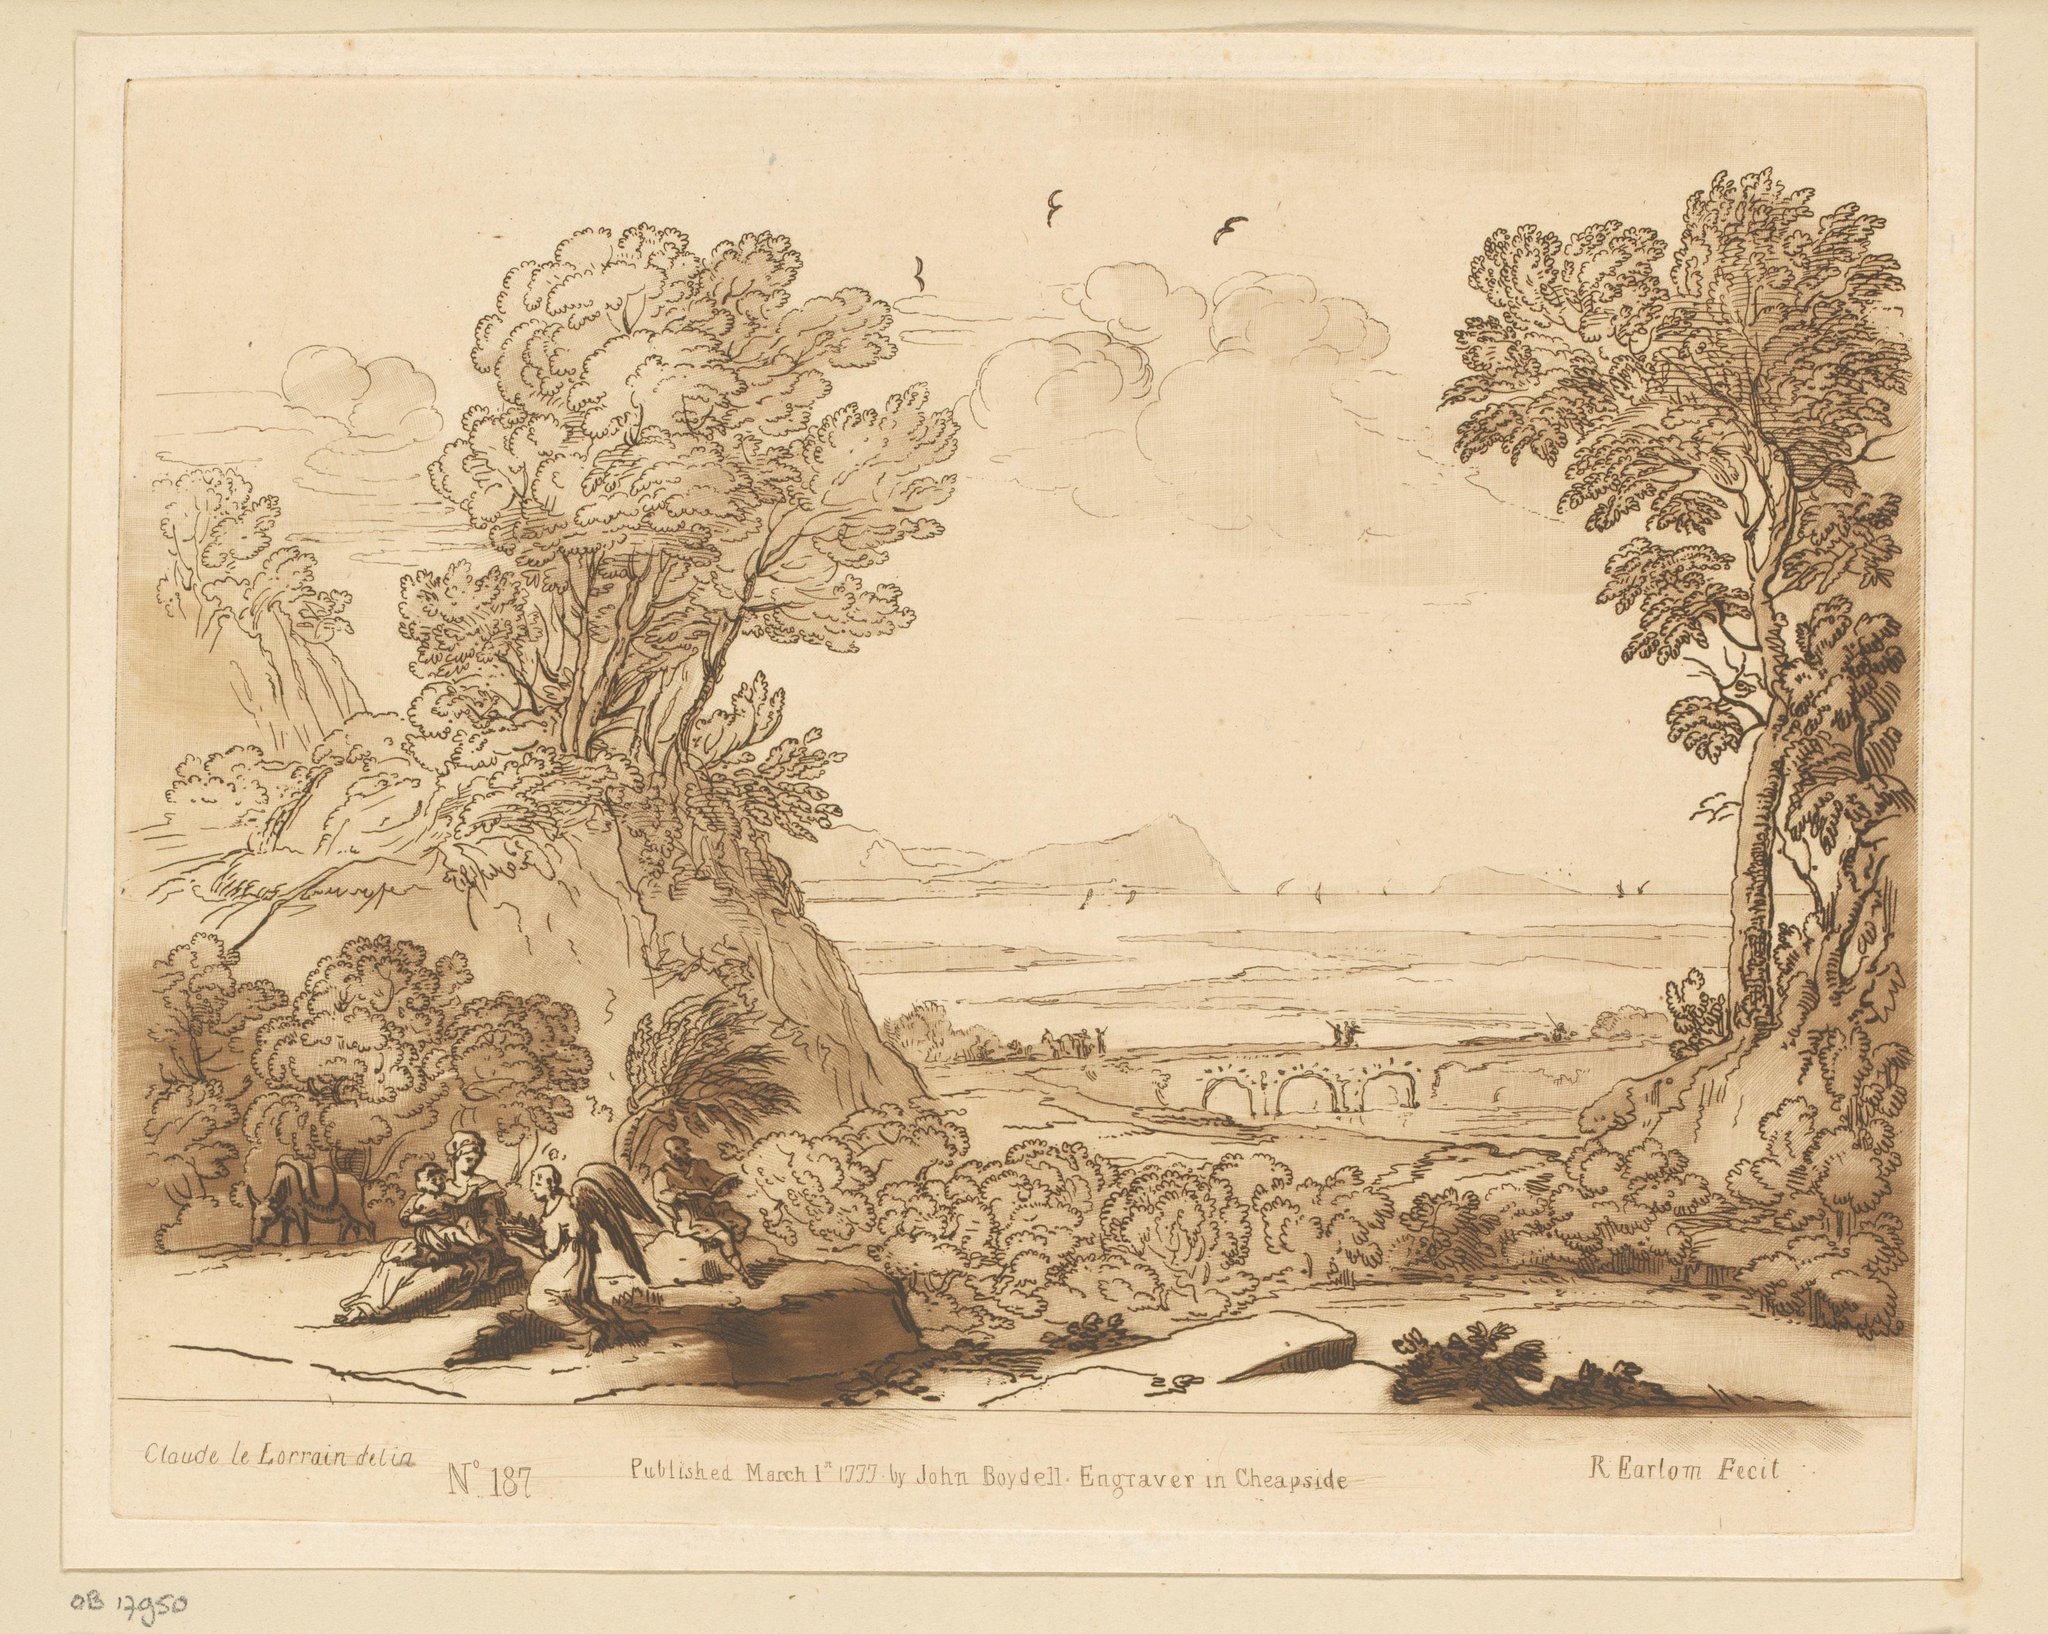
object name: print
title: Prenten naar tekeningen van Claude Lorrain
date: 1777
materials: paper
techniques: etching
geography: london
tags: rest on the flight into egypt - bb - landscape predominant (+angel(s)), landscape with bridge, viaduct or aqueduct - ii - ideal landscapes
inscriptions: date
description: Vanaf 1774 publiceerde John Boydell tweehonderd prenten naar het tekeningenboek Liber Veritatis van Claude Lorrain, in het bezit van de hertogen van Cavendish. Deze prenten werden vanaf 1777 in twee volumes gebundeld uitgegeven.